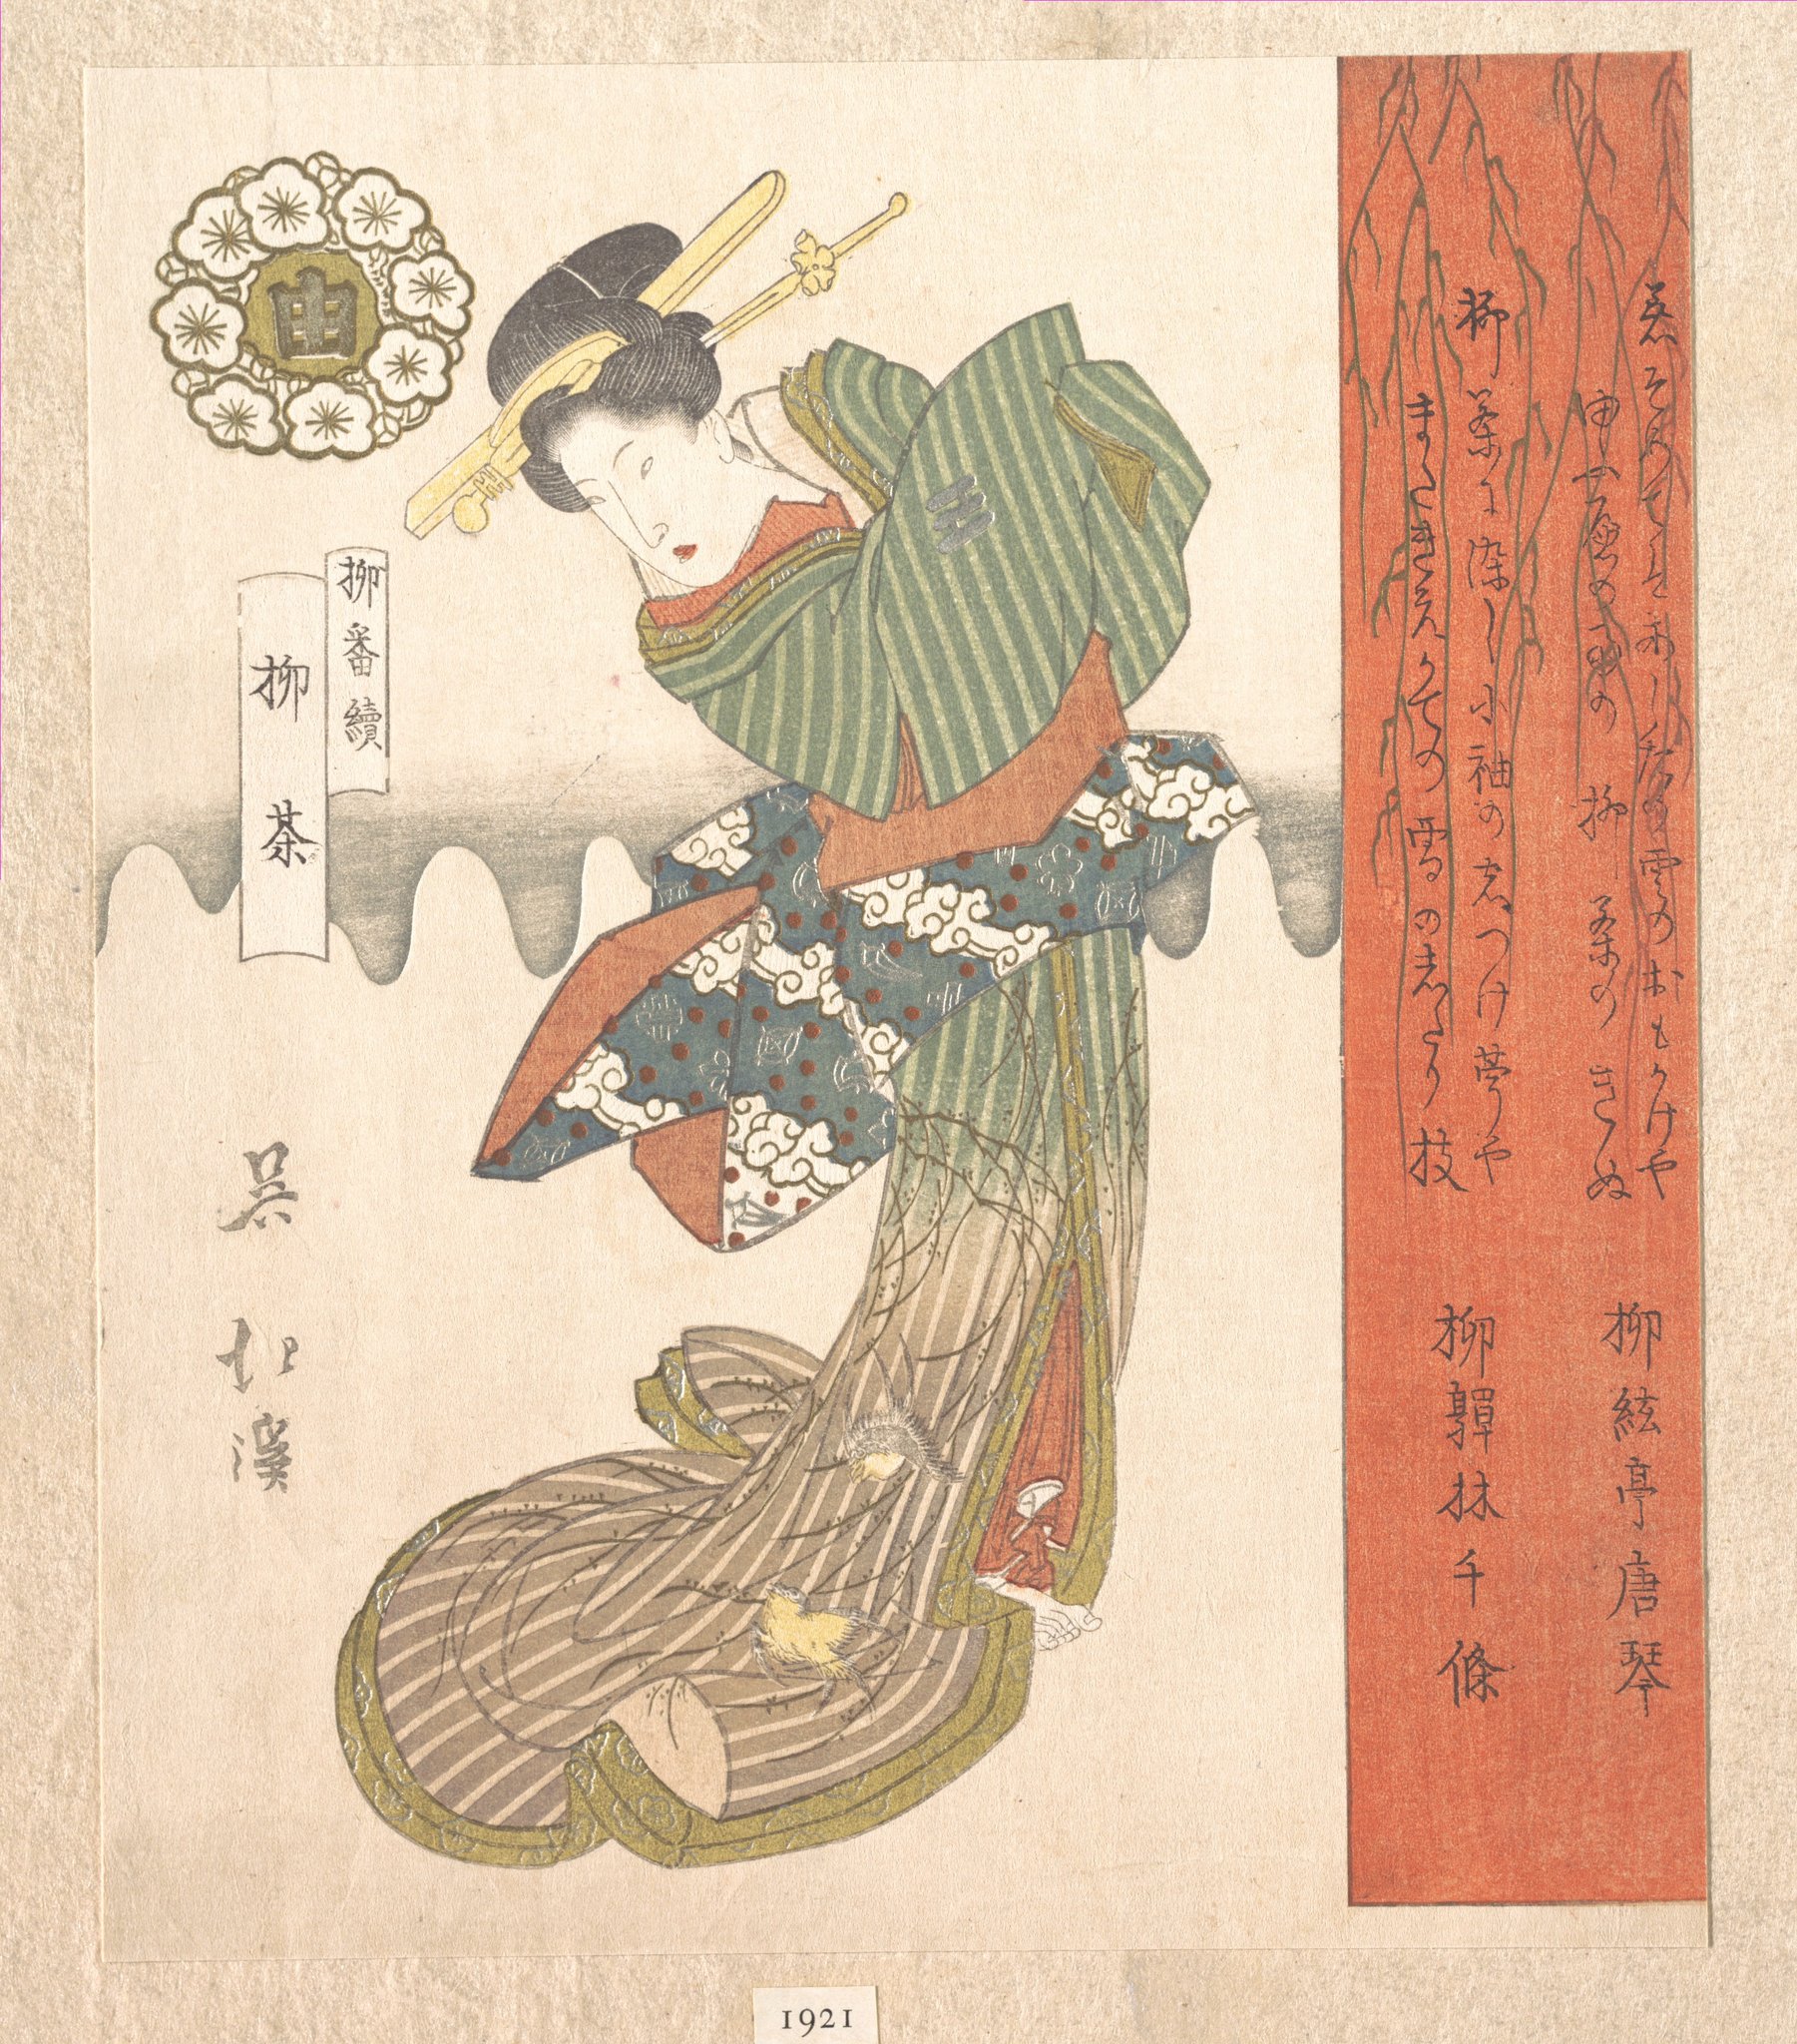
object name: print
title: Courtesan Dancing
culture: japanese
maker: totoya hokkei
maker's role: artist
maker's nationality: japanese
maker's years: 1780-1850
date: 1801-1833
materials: ink, paper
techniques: surimono, woodblock print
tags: women,dancing